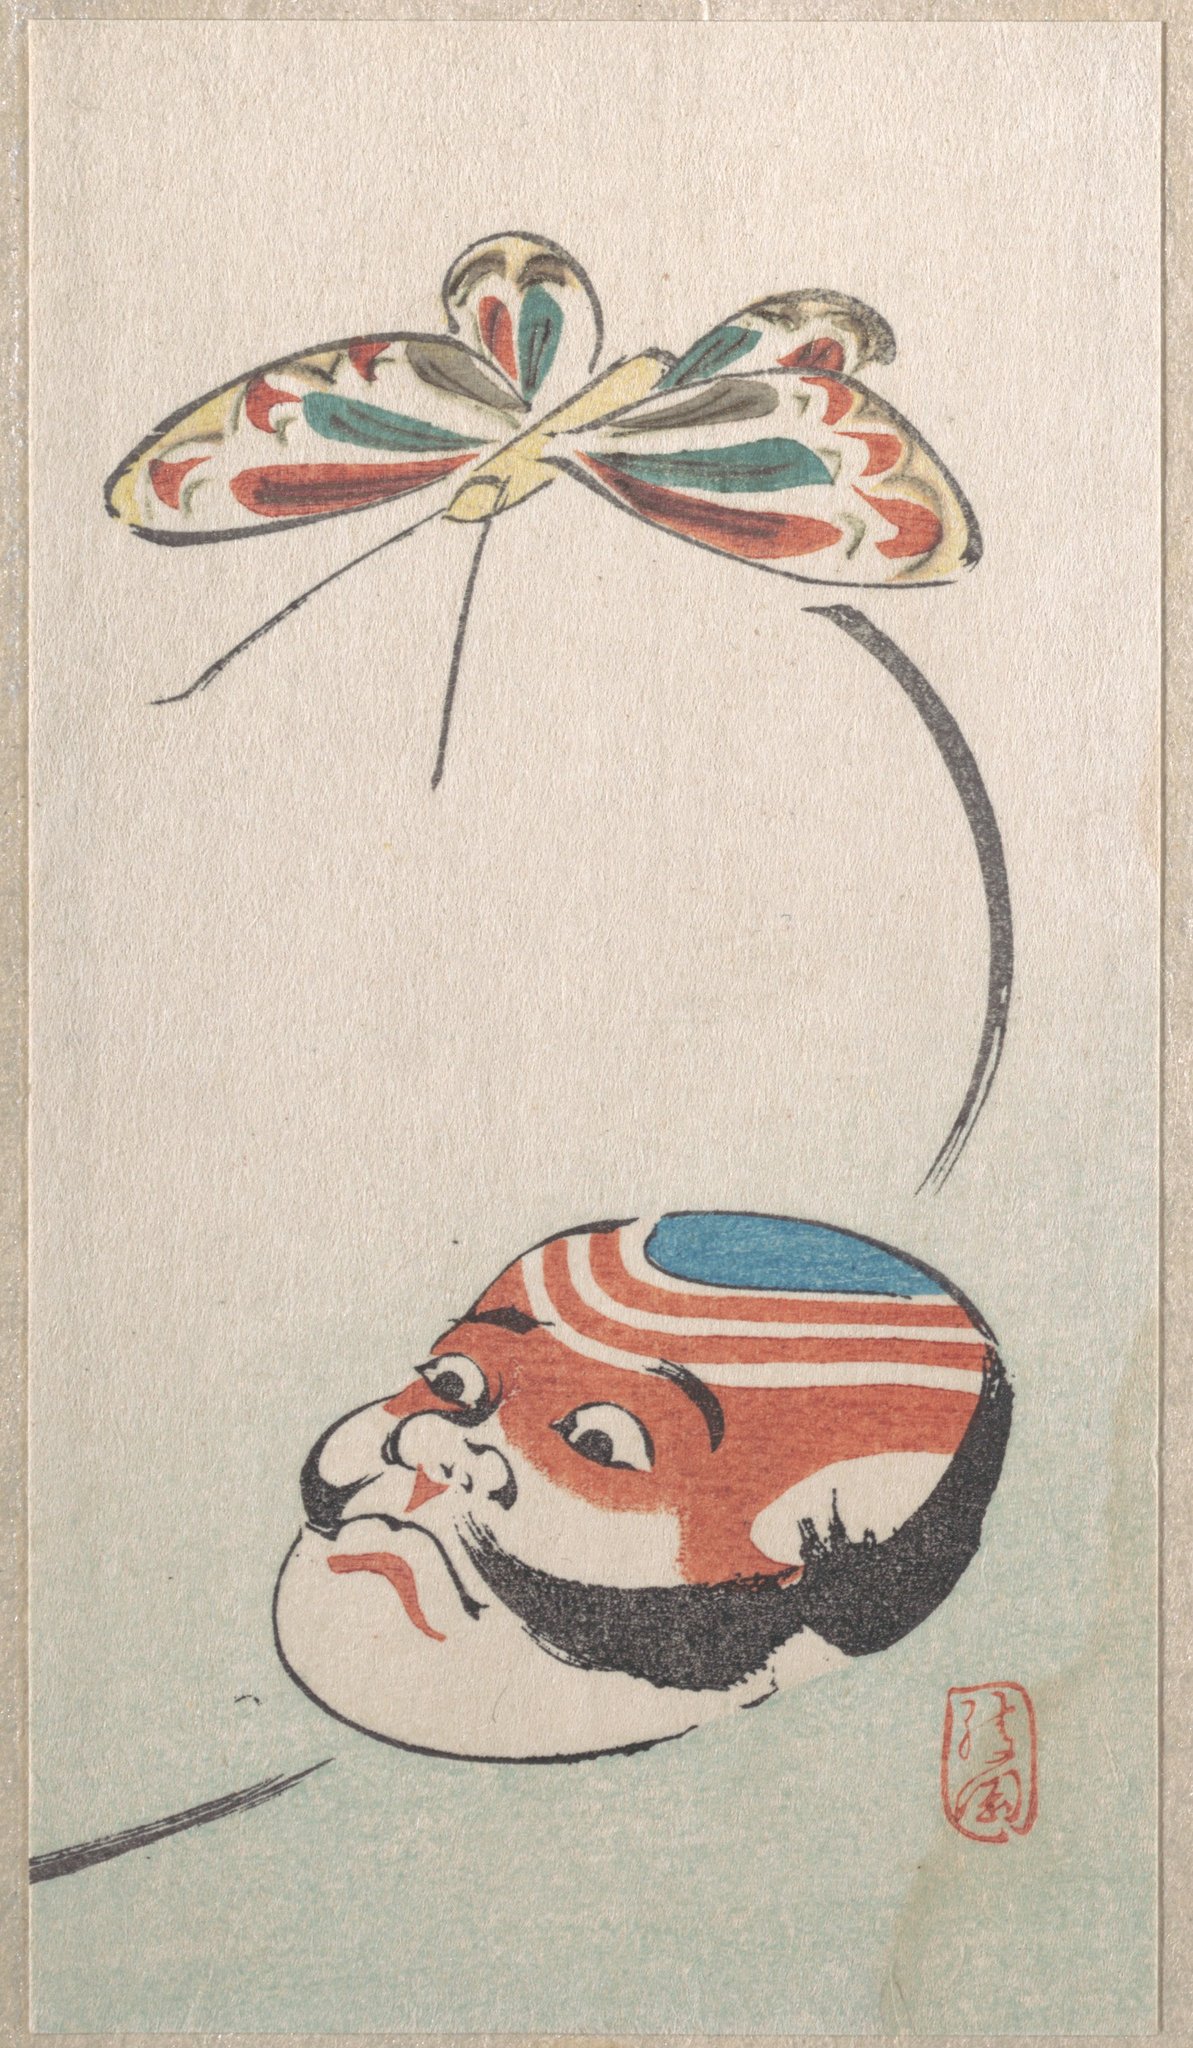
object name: print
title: Butterfly and Mask of Yakko (the footman of a samurai)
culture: japanese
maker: ayaoka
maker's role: artist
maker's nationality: japanese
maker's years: 1800-1900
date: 1701-1900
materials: ink, paper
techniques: surimono, woodblock print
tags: masks,butterflies